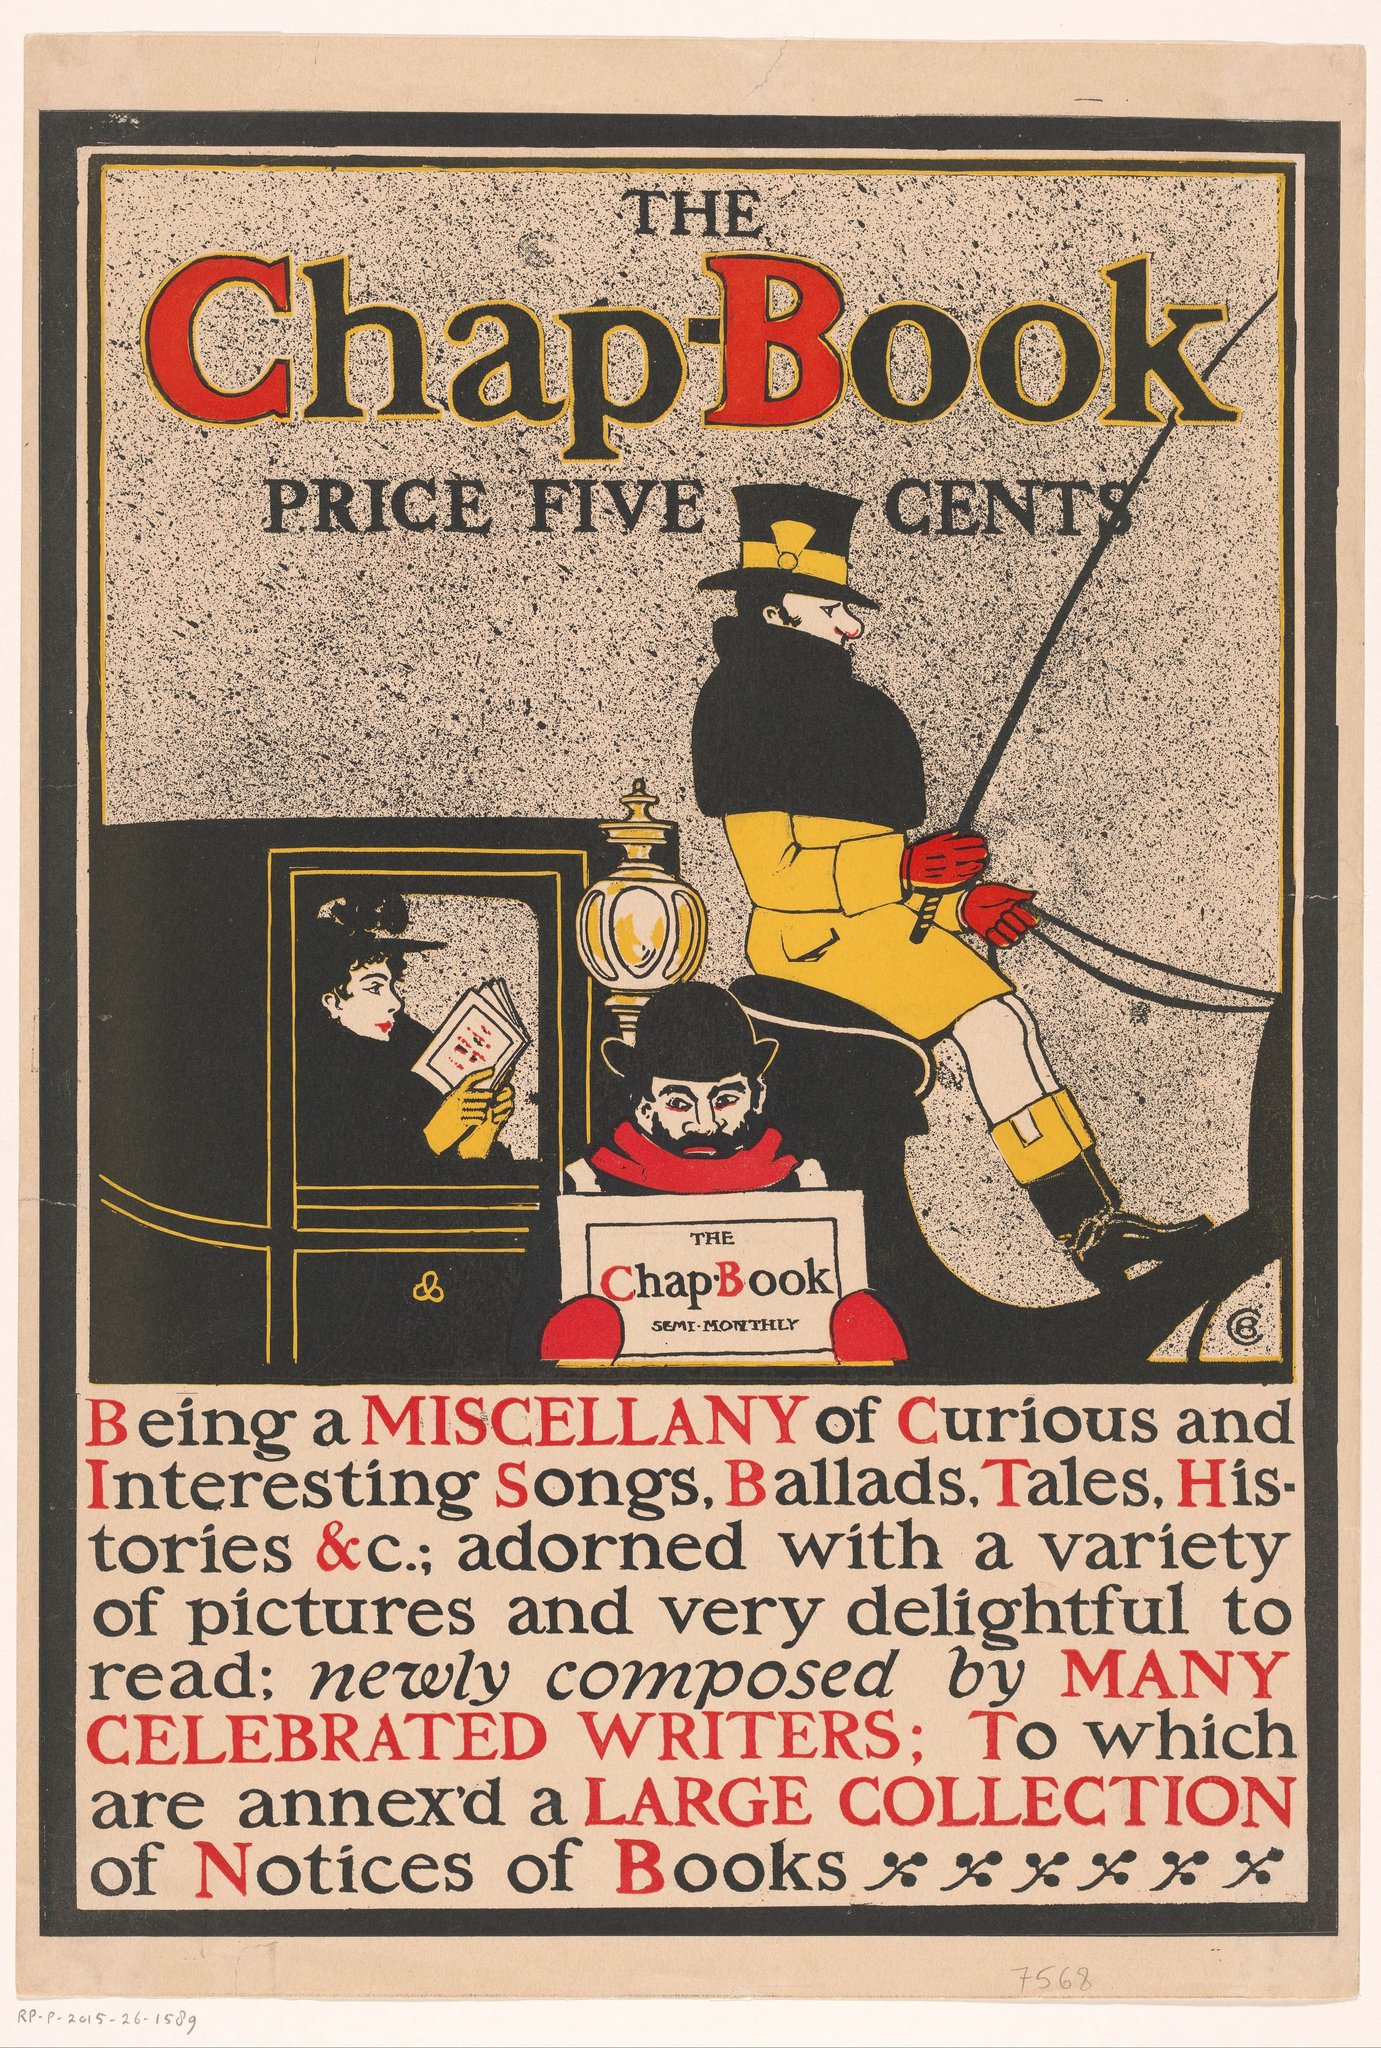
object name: print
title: Reclamebiljet voor het tijdschrift The Chap-Book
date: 1896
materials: paper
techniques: lithograph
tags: reading, sandwich-man, four-wheeled, animal-drawn vehicle, e.g.: cab, carriage, coach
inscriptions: collector's mark: Lugt 4779, annotation: ‘Claude Bragdon’, collector's mark: Lugt 2228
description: Koets met een koetsier op de bok en in het rijtuig een lezende vrouw. Op de voorgrond houdt een man met een bolhoed en een sjaal een reclamebord vast.